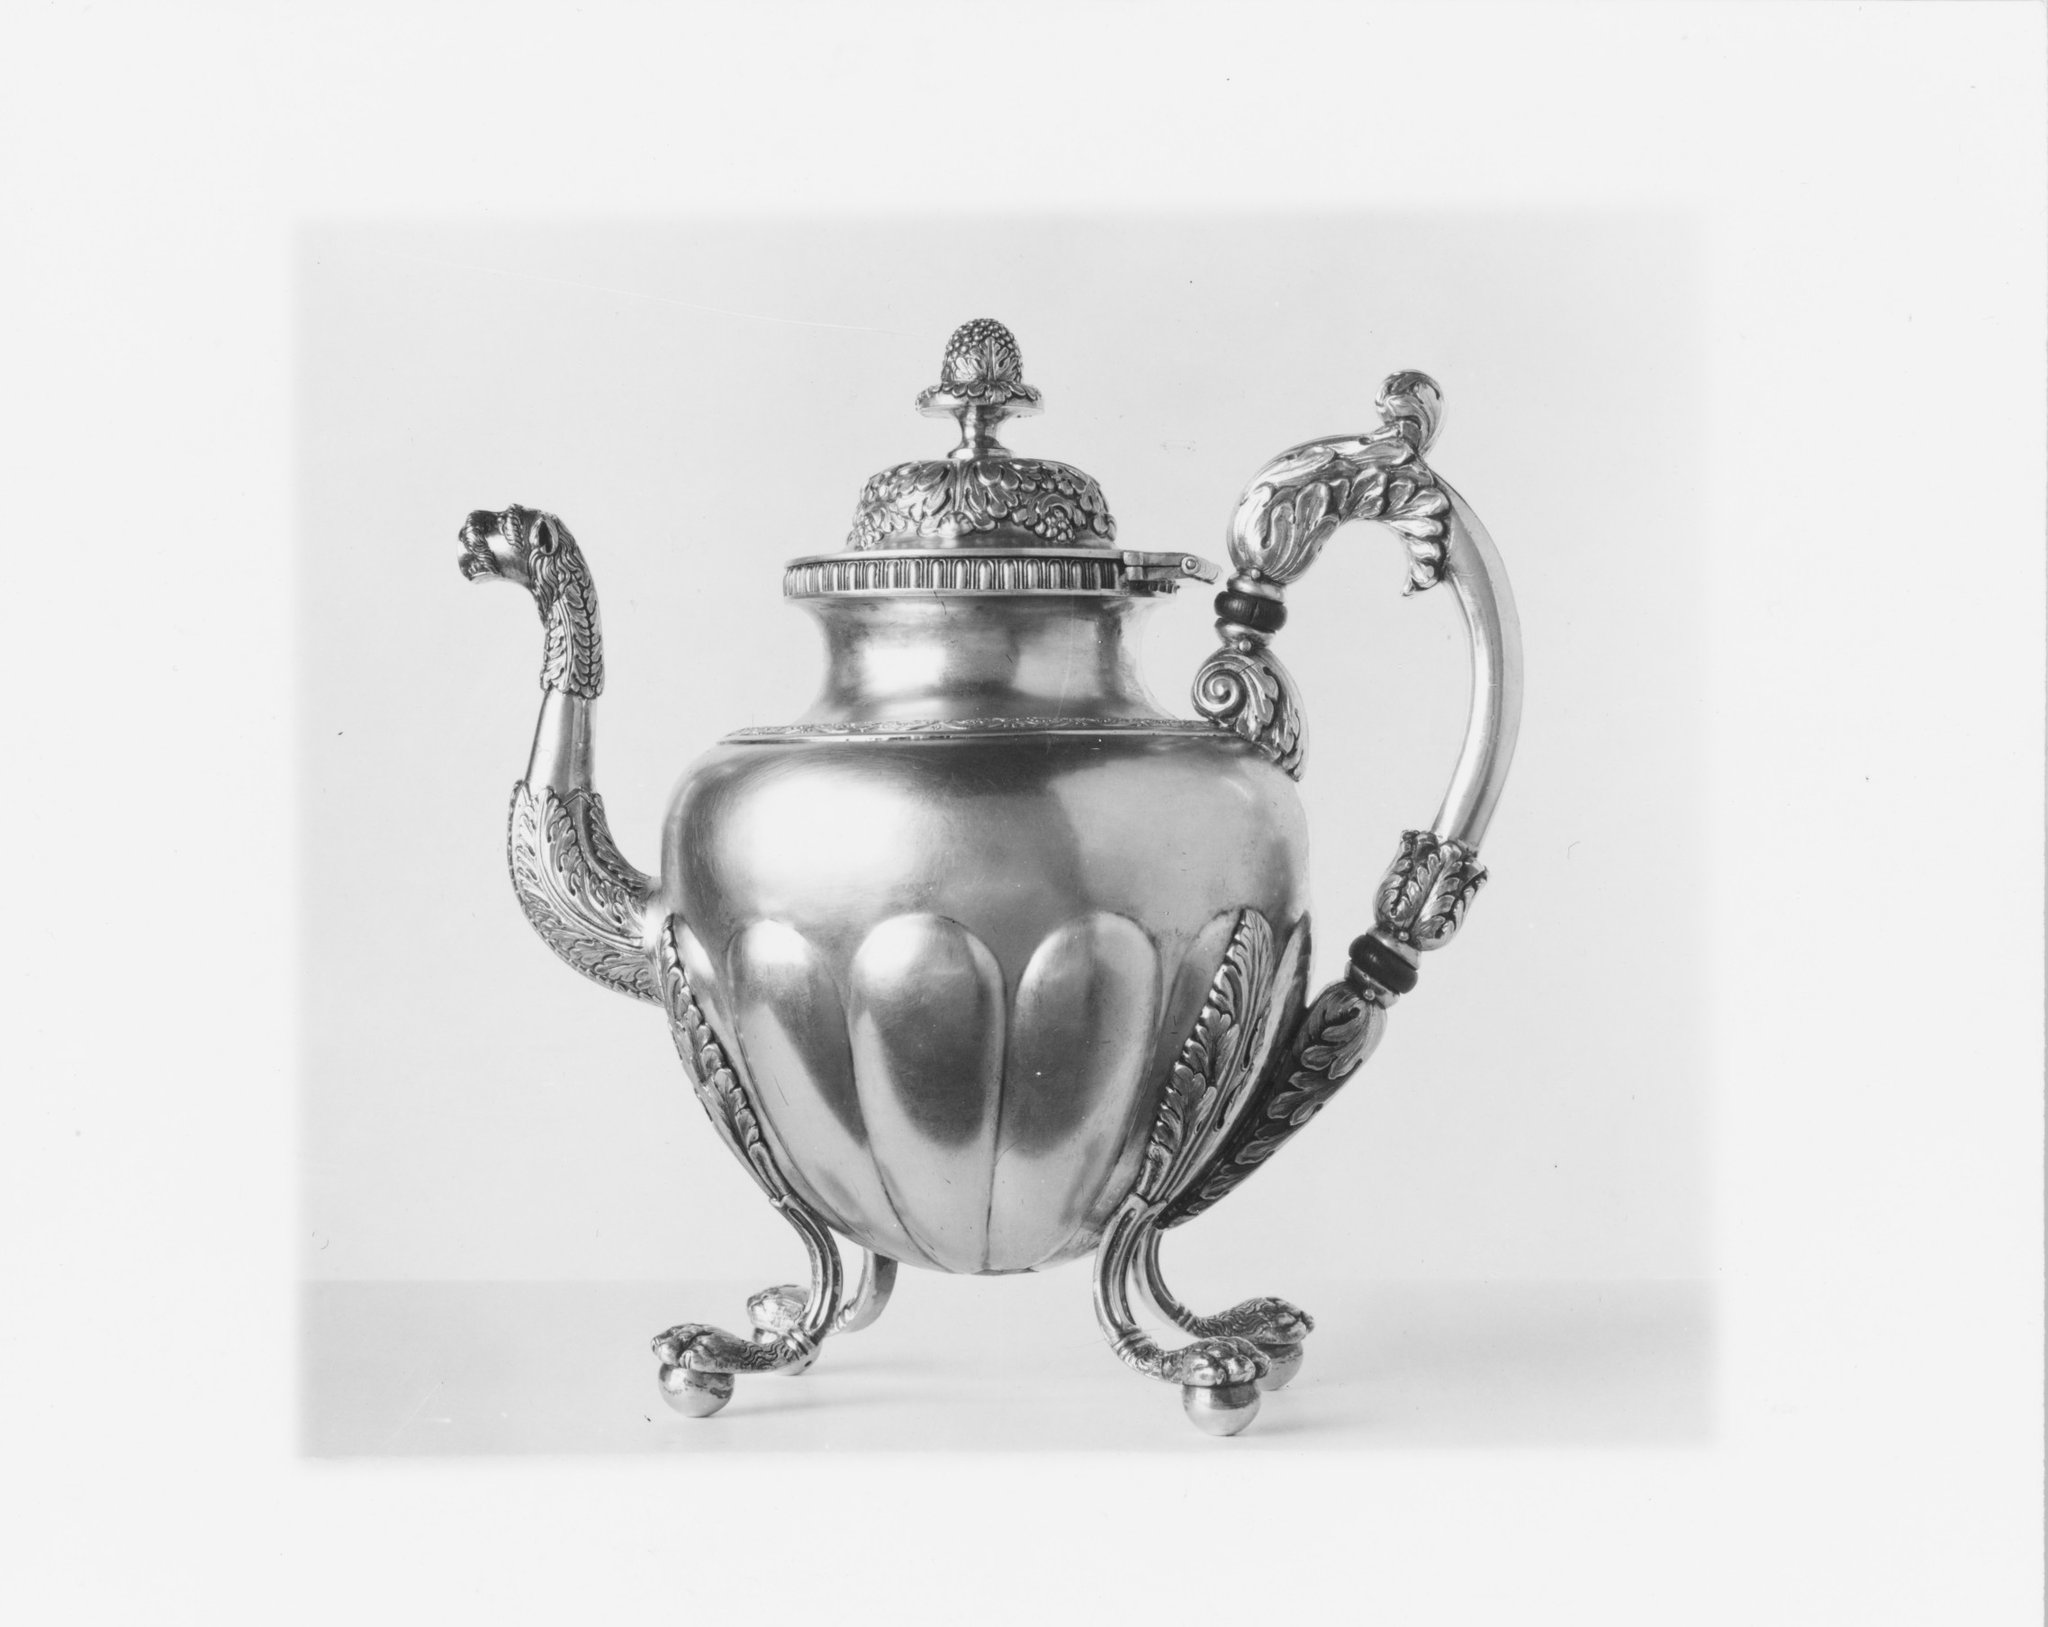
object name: teapot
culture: american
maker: garrett eoff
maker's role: maker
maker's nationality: american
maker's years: 1779-1845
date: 1825-1845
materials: silver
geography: united states